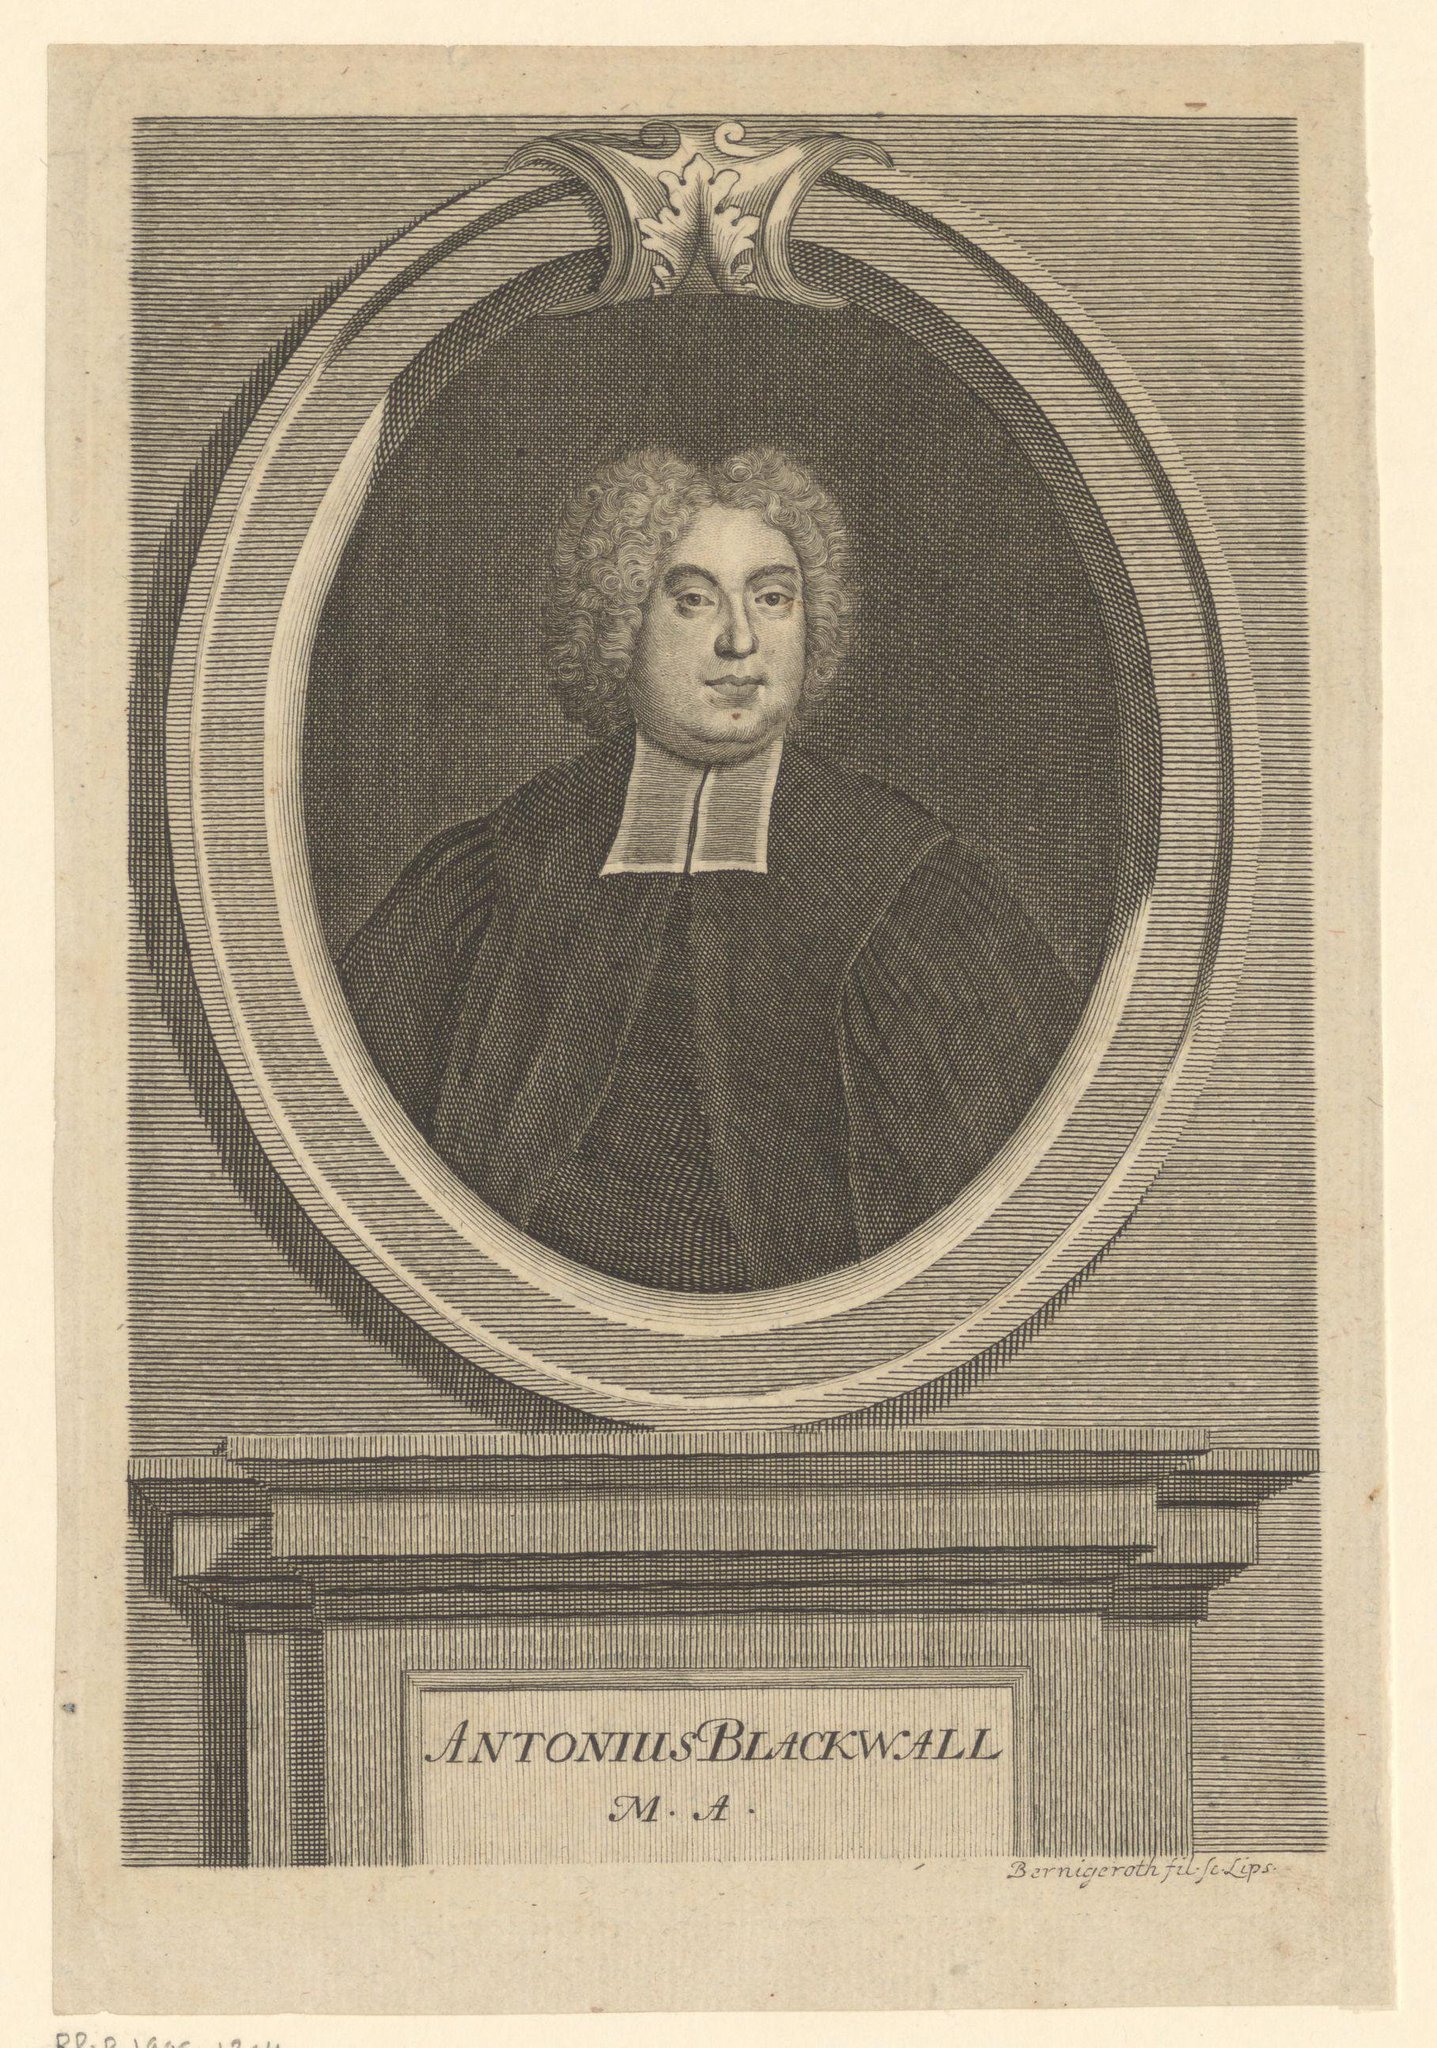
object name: print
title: Portret van Anthony Blackwall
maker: johann martin bernigeroth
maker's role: print maker, publisher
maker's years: 1713-1767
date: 1736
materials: paper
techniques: engraving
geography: leipzig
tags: historical persons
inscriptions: collector's mark: Lugt 2228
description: Prent ook gebruikt in: Blackwall, Anthony. Auctores sacri classici defensi et illustrati [vertaald uit het Engels door] Christoph Wollius. Leipzig: Johann Christian Martini, 1736.